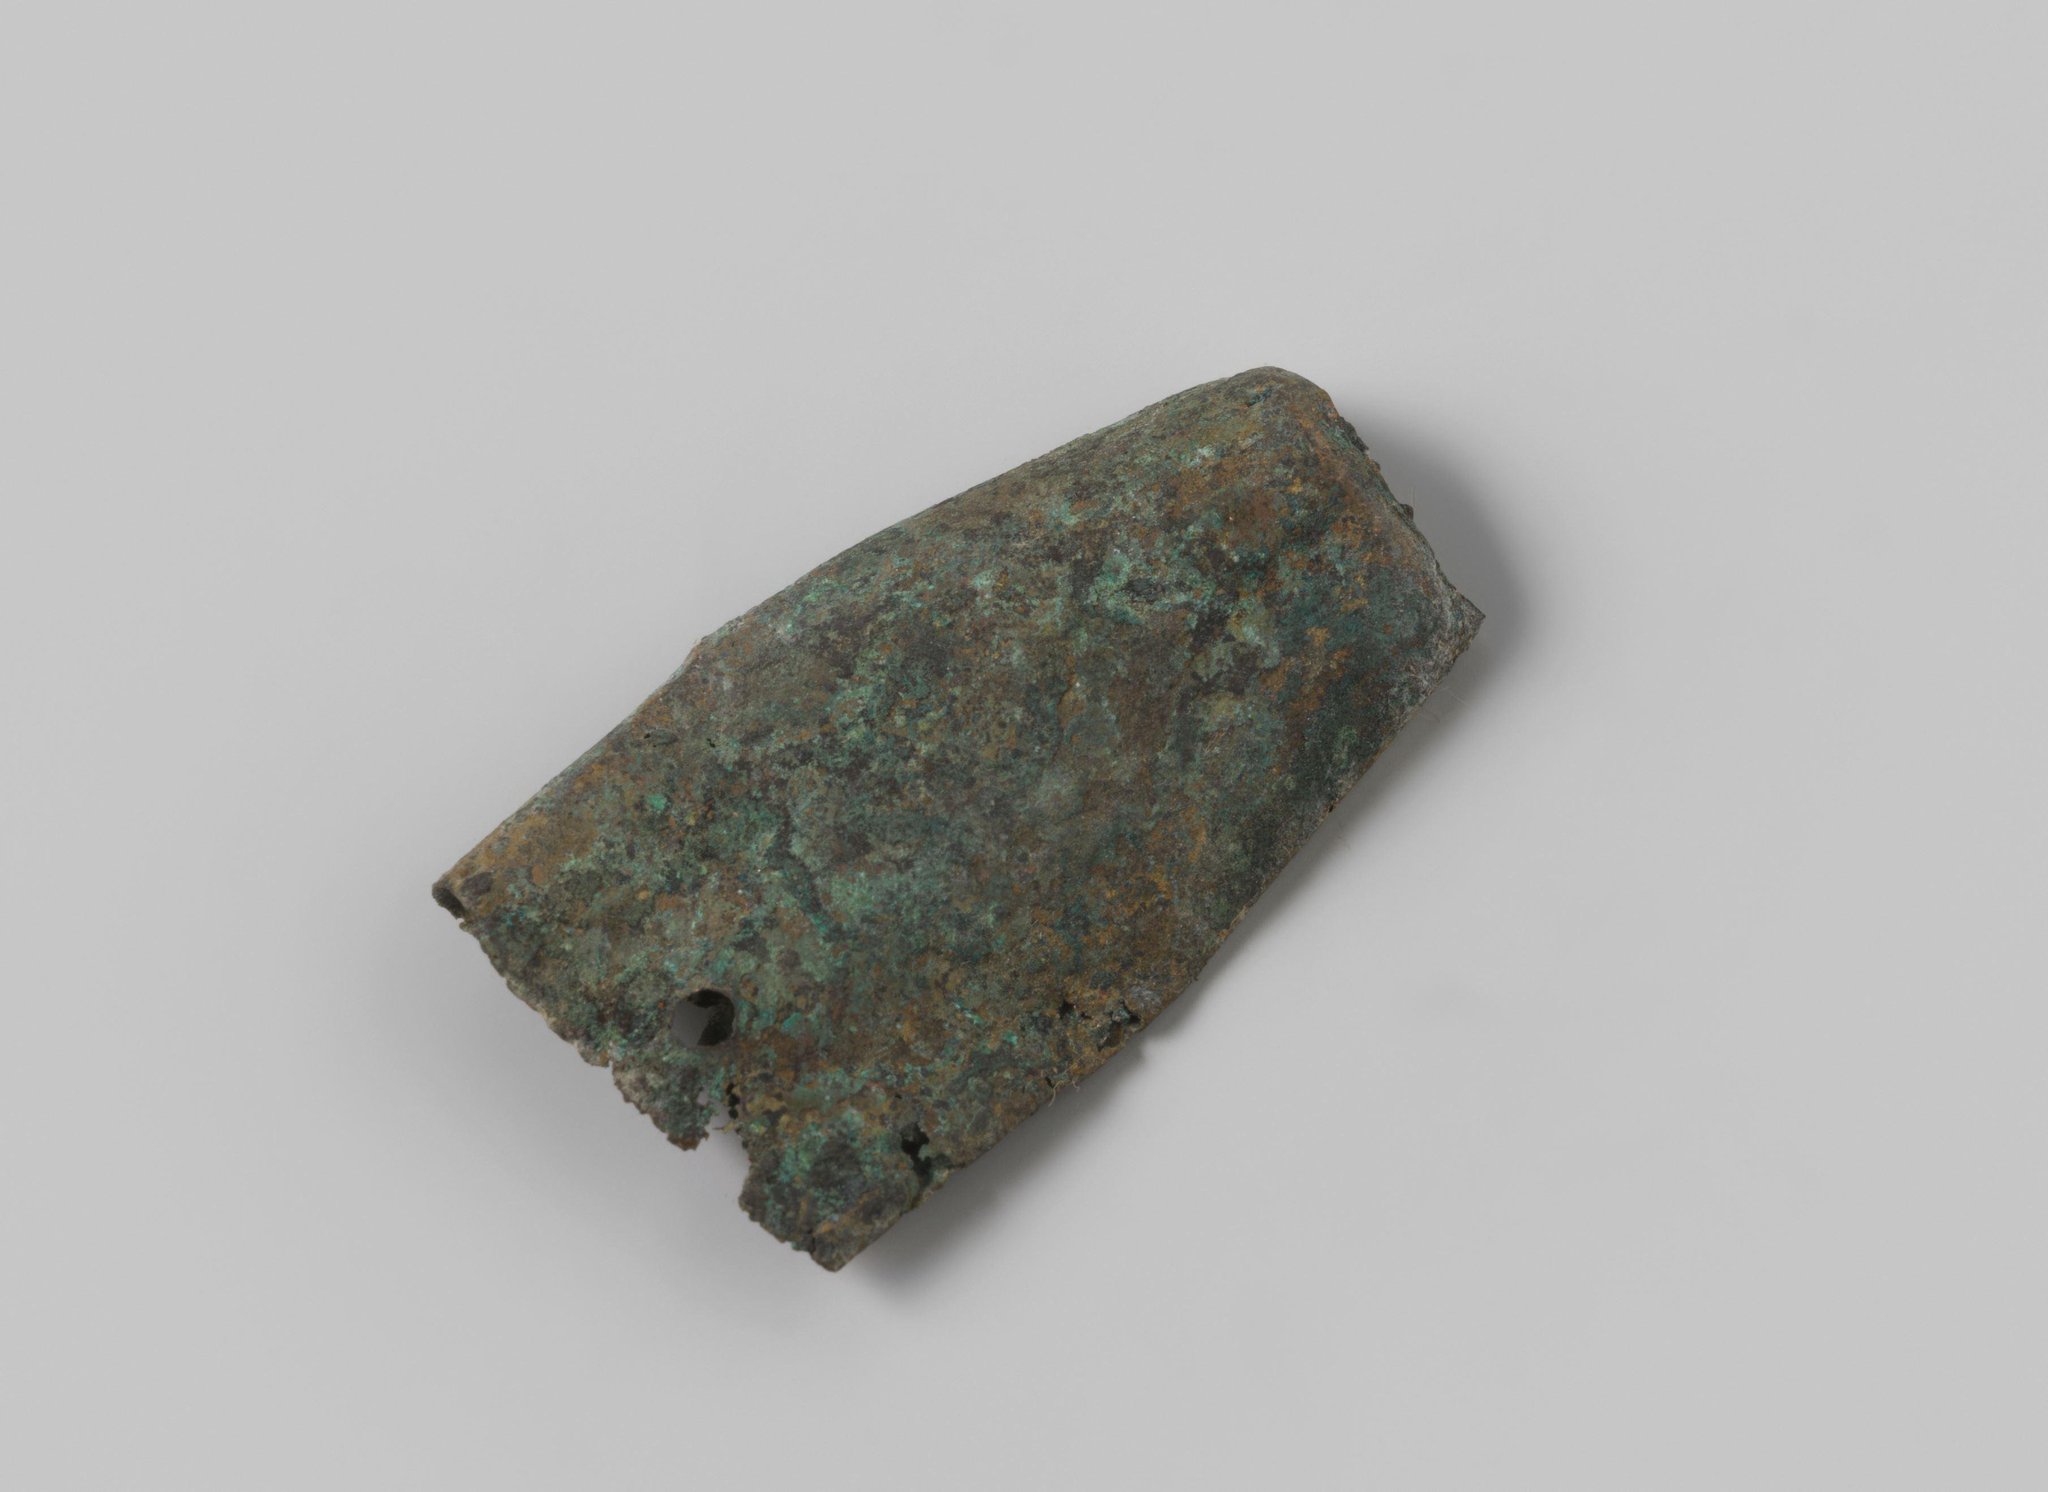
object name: powder horn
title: Fragment van een kruithoorn uit het wrak van de Oost-Indiëvaarder Hollandia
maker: Anonymous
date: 1700-1743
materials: copper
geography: netherlands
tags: verenigde oostindische compagnie, hollandia (schip), annet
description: Powderhorn, nozzle; fragm, id. NG 1979-52/53H636, squashed, eroded.